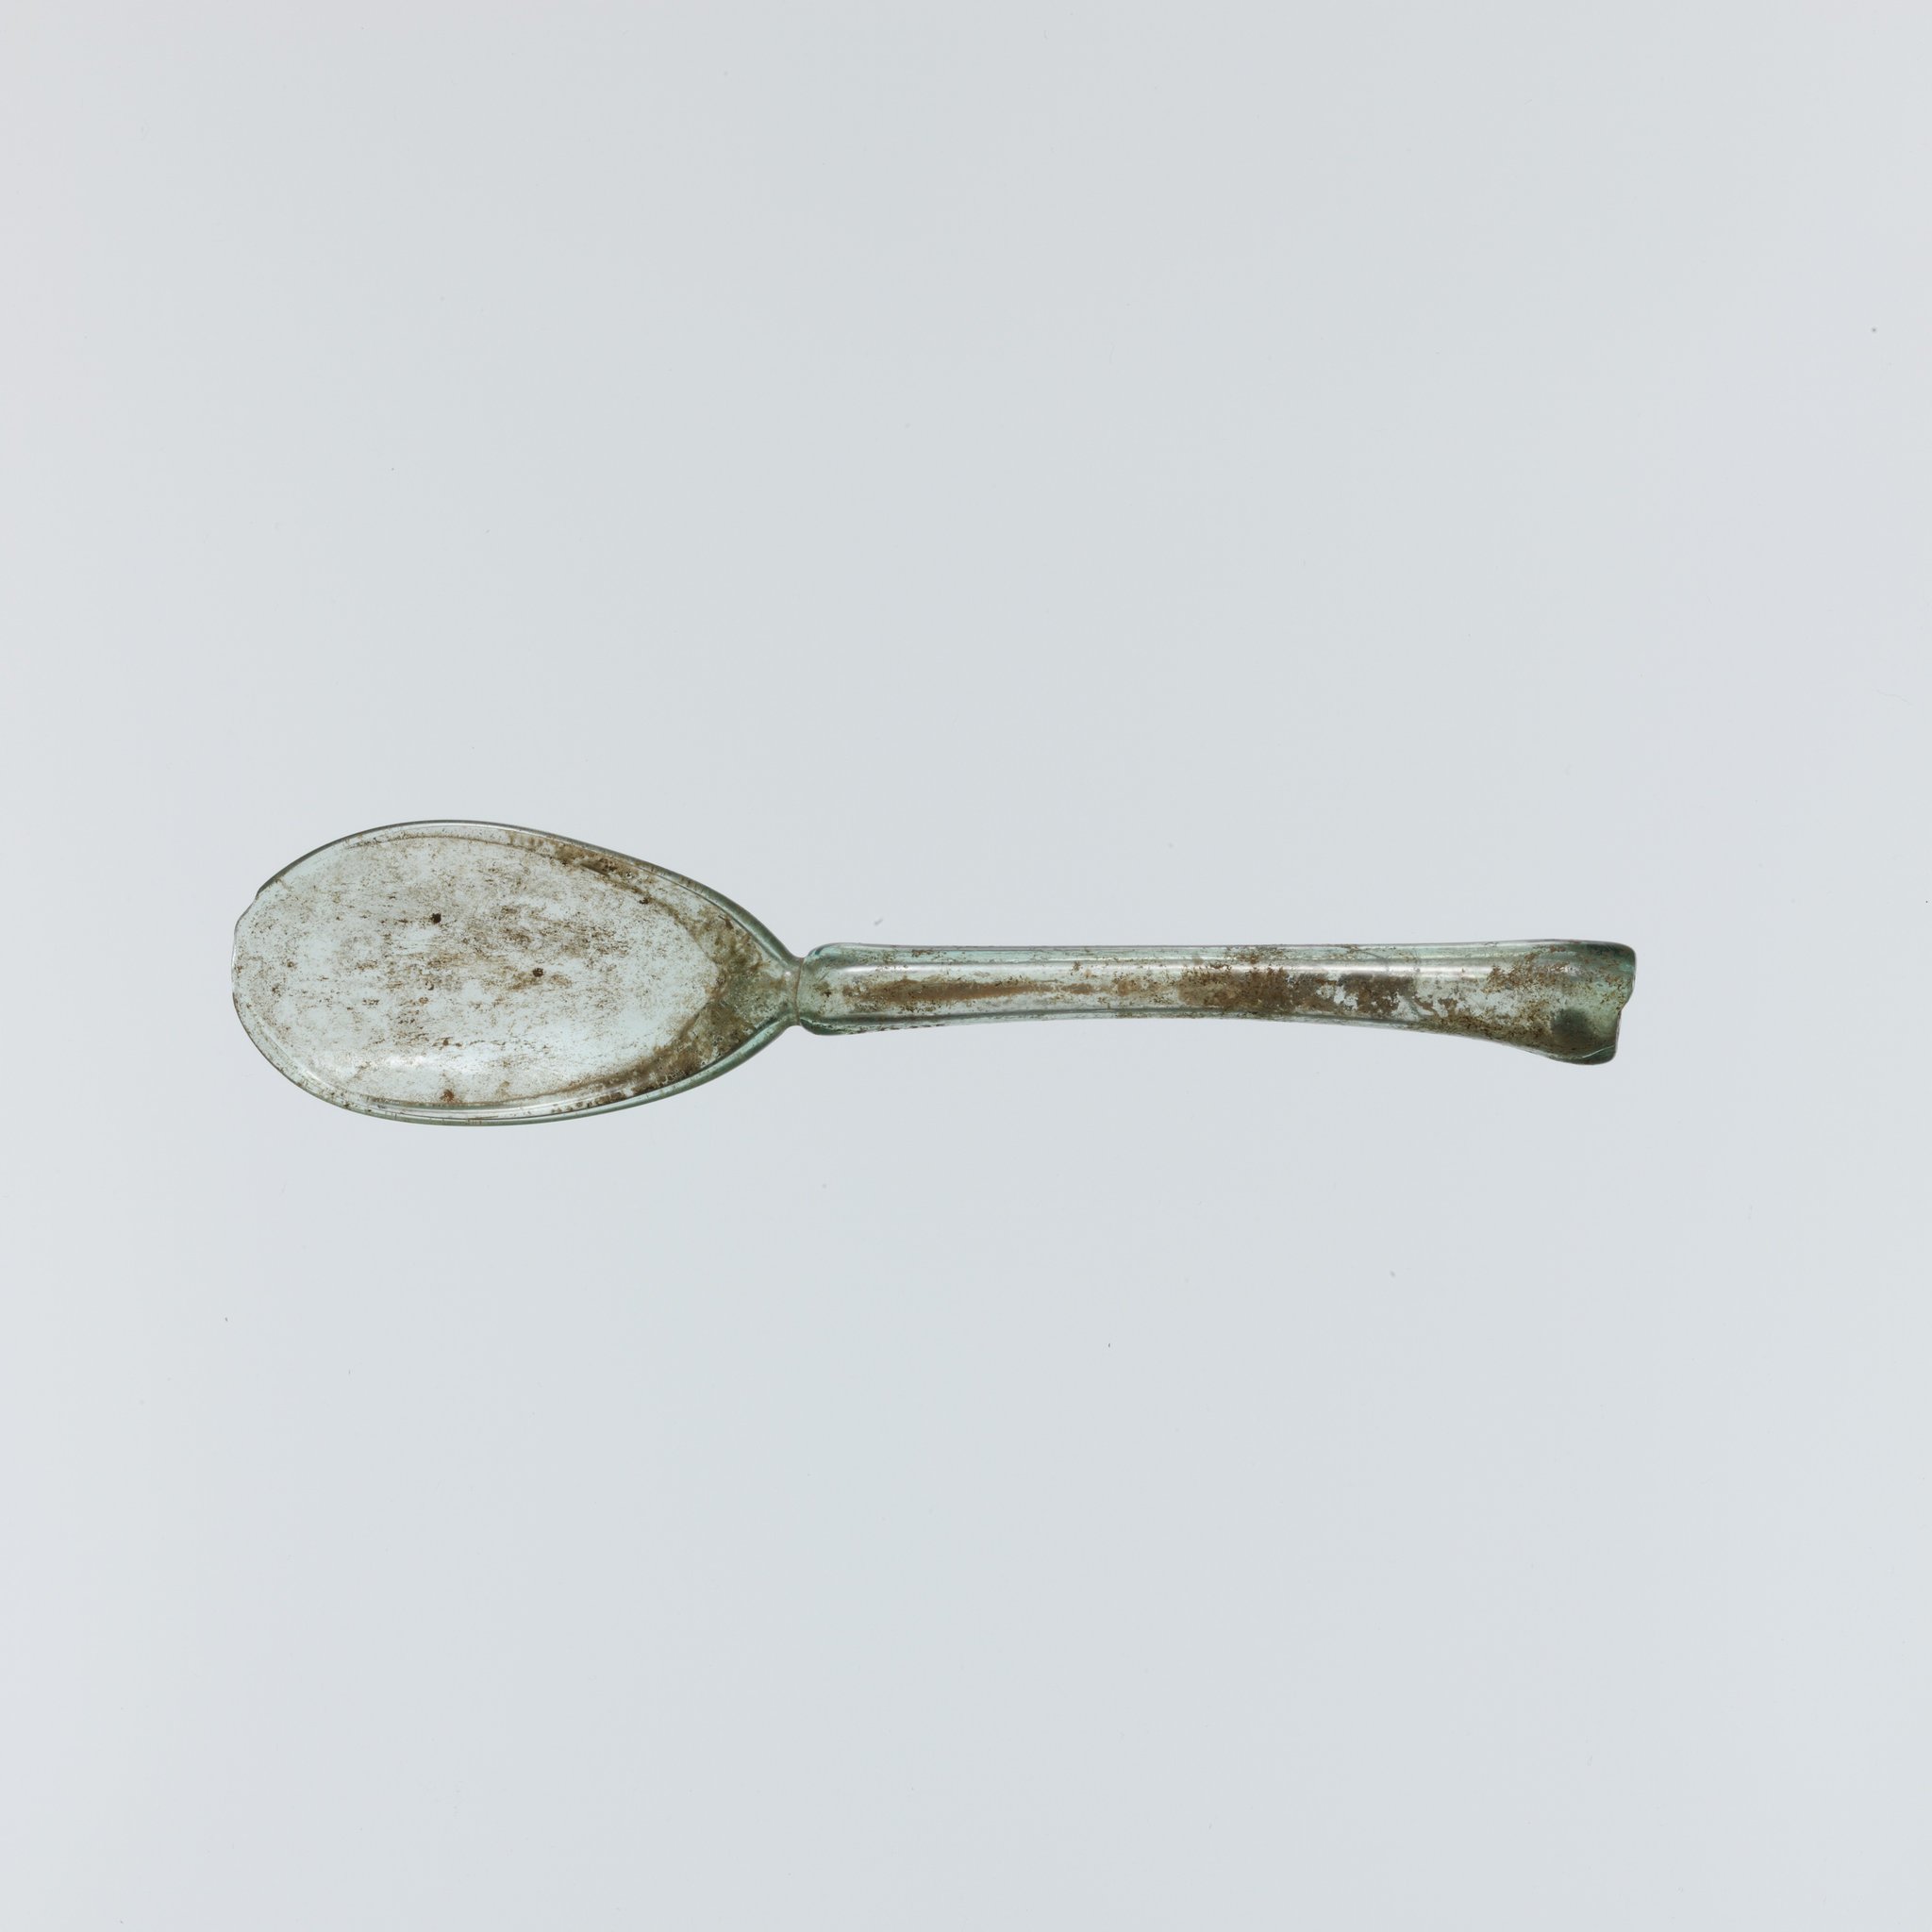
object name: spoon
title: Glass spoon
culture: roman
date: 1-300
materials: glass